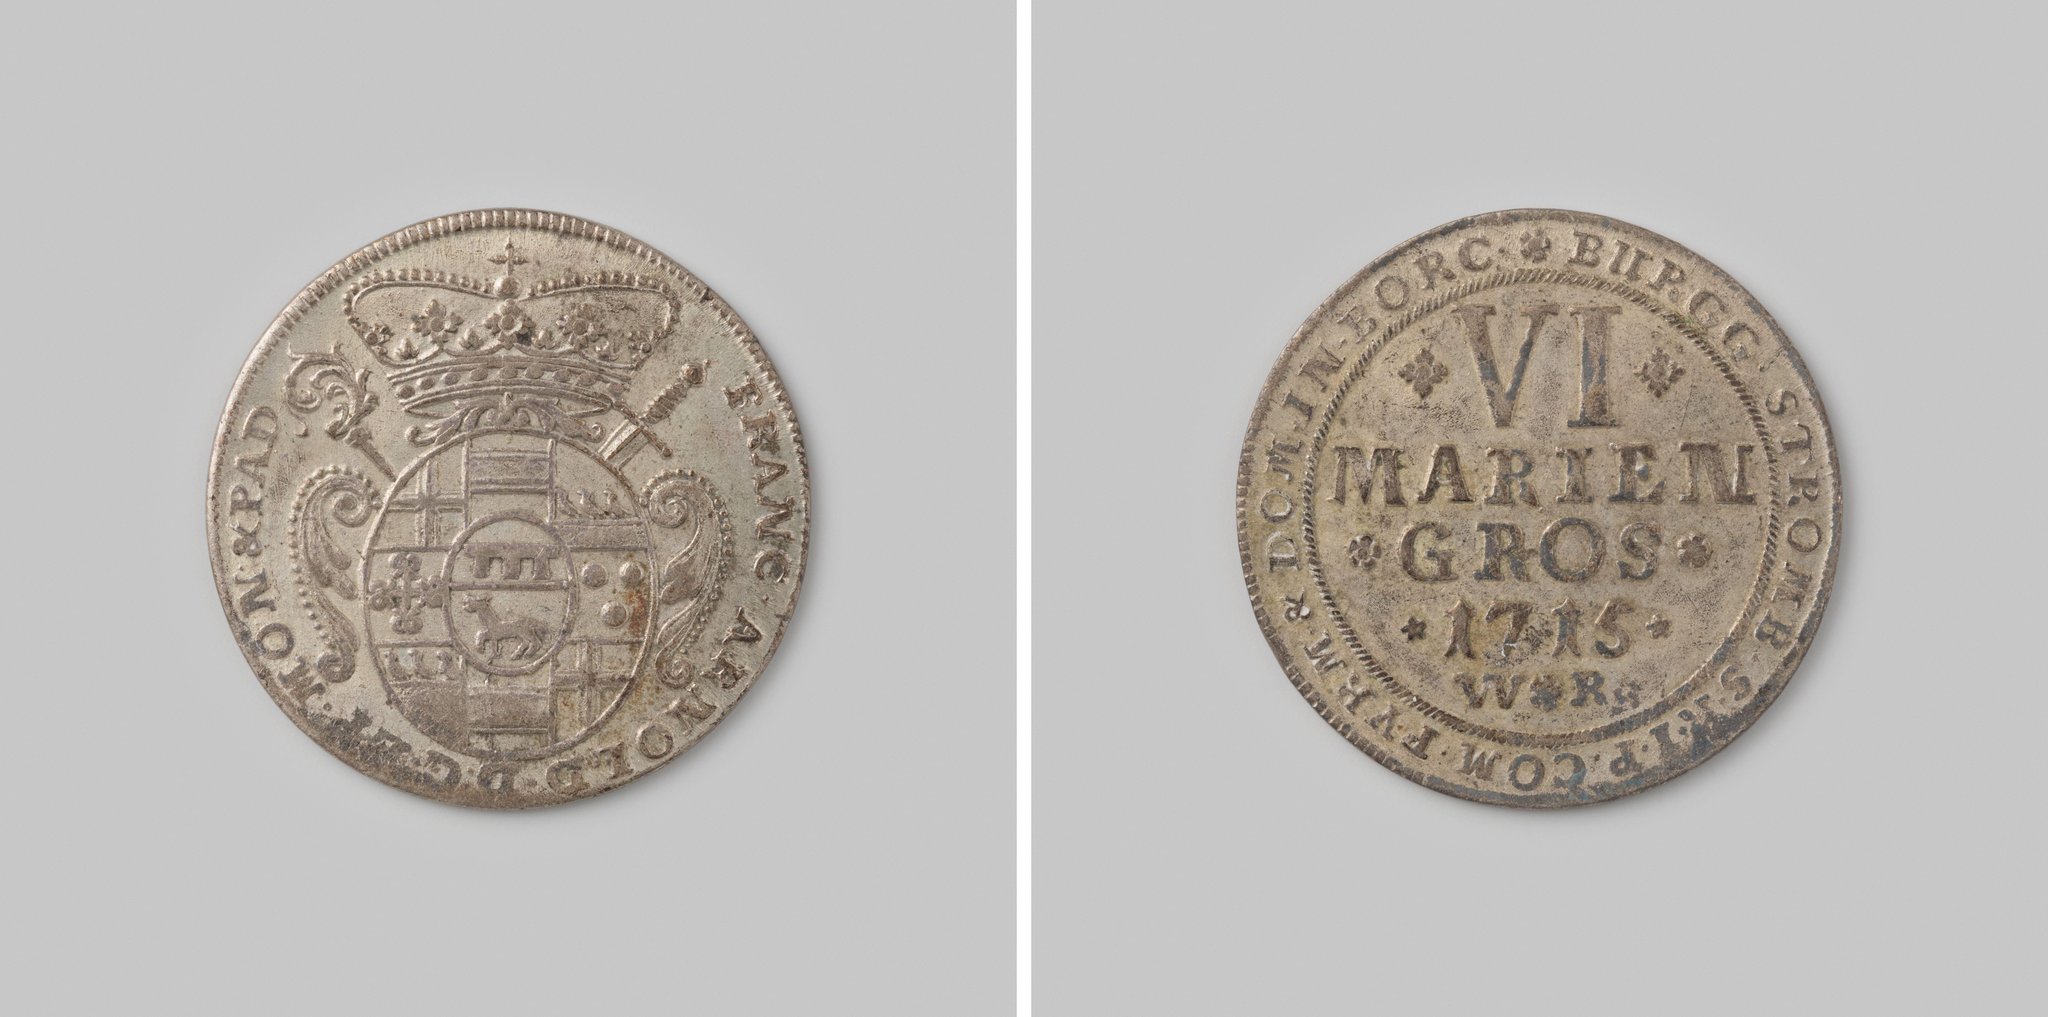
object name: coin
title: 6 mariengroschen uit het bisdom Münster van Franz Arnold,1715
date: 1715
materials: silver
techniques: striking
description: Zilveren munt. Voorzijde: op een bisschopsstaf en een zwaard versierd samengesteld wapenschild, waarop kroon. Keerzijde: waarde-aanduiding in drie regels, waaronder jaartal. Gladde rand.